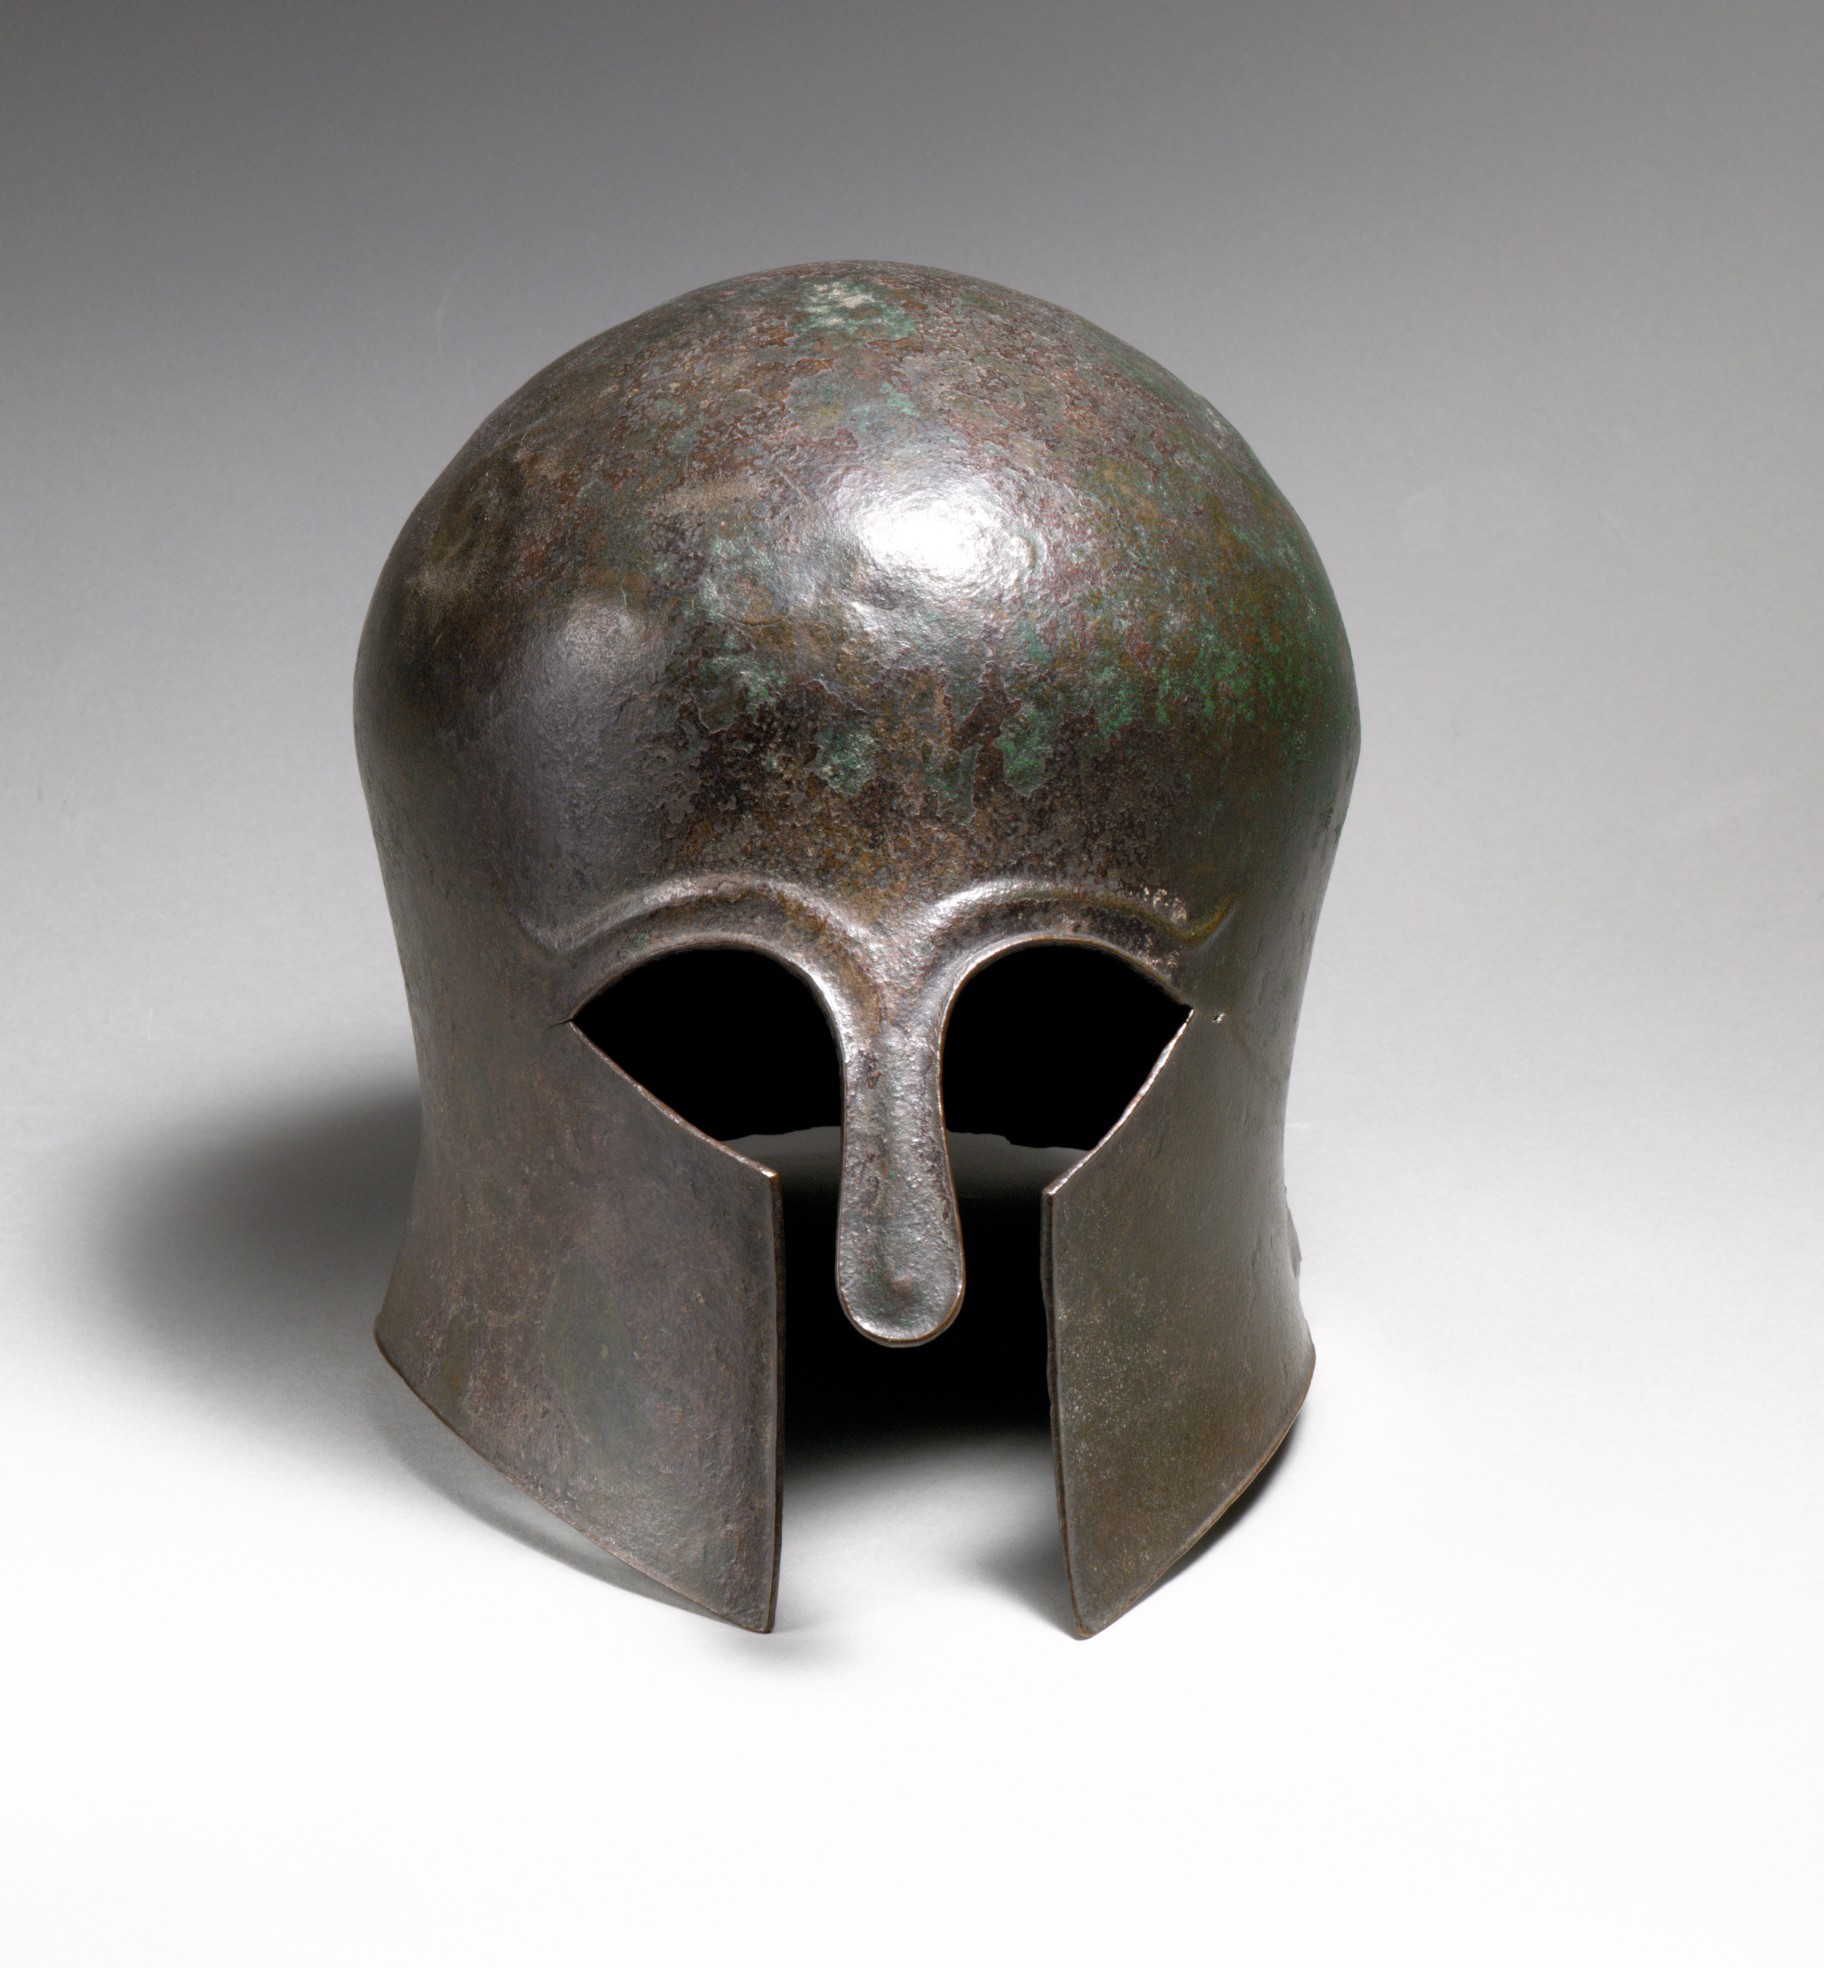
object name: helmet of corinthian type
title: Bronze helmet of the Corinthian type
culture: greek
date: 600-501 BCE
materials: bronze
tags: helmets